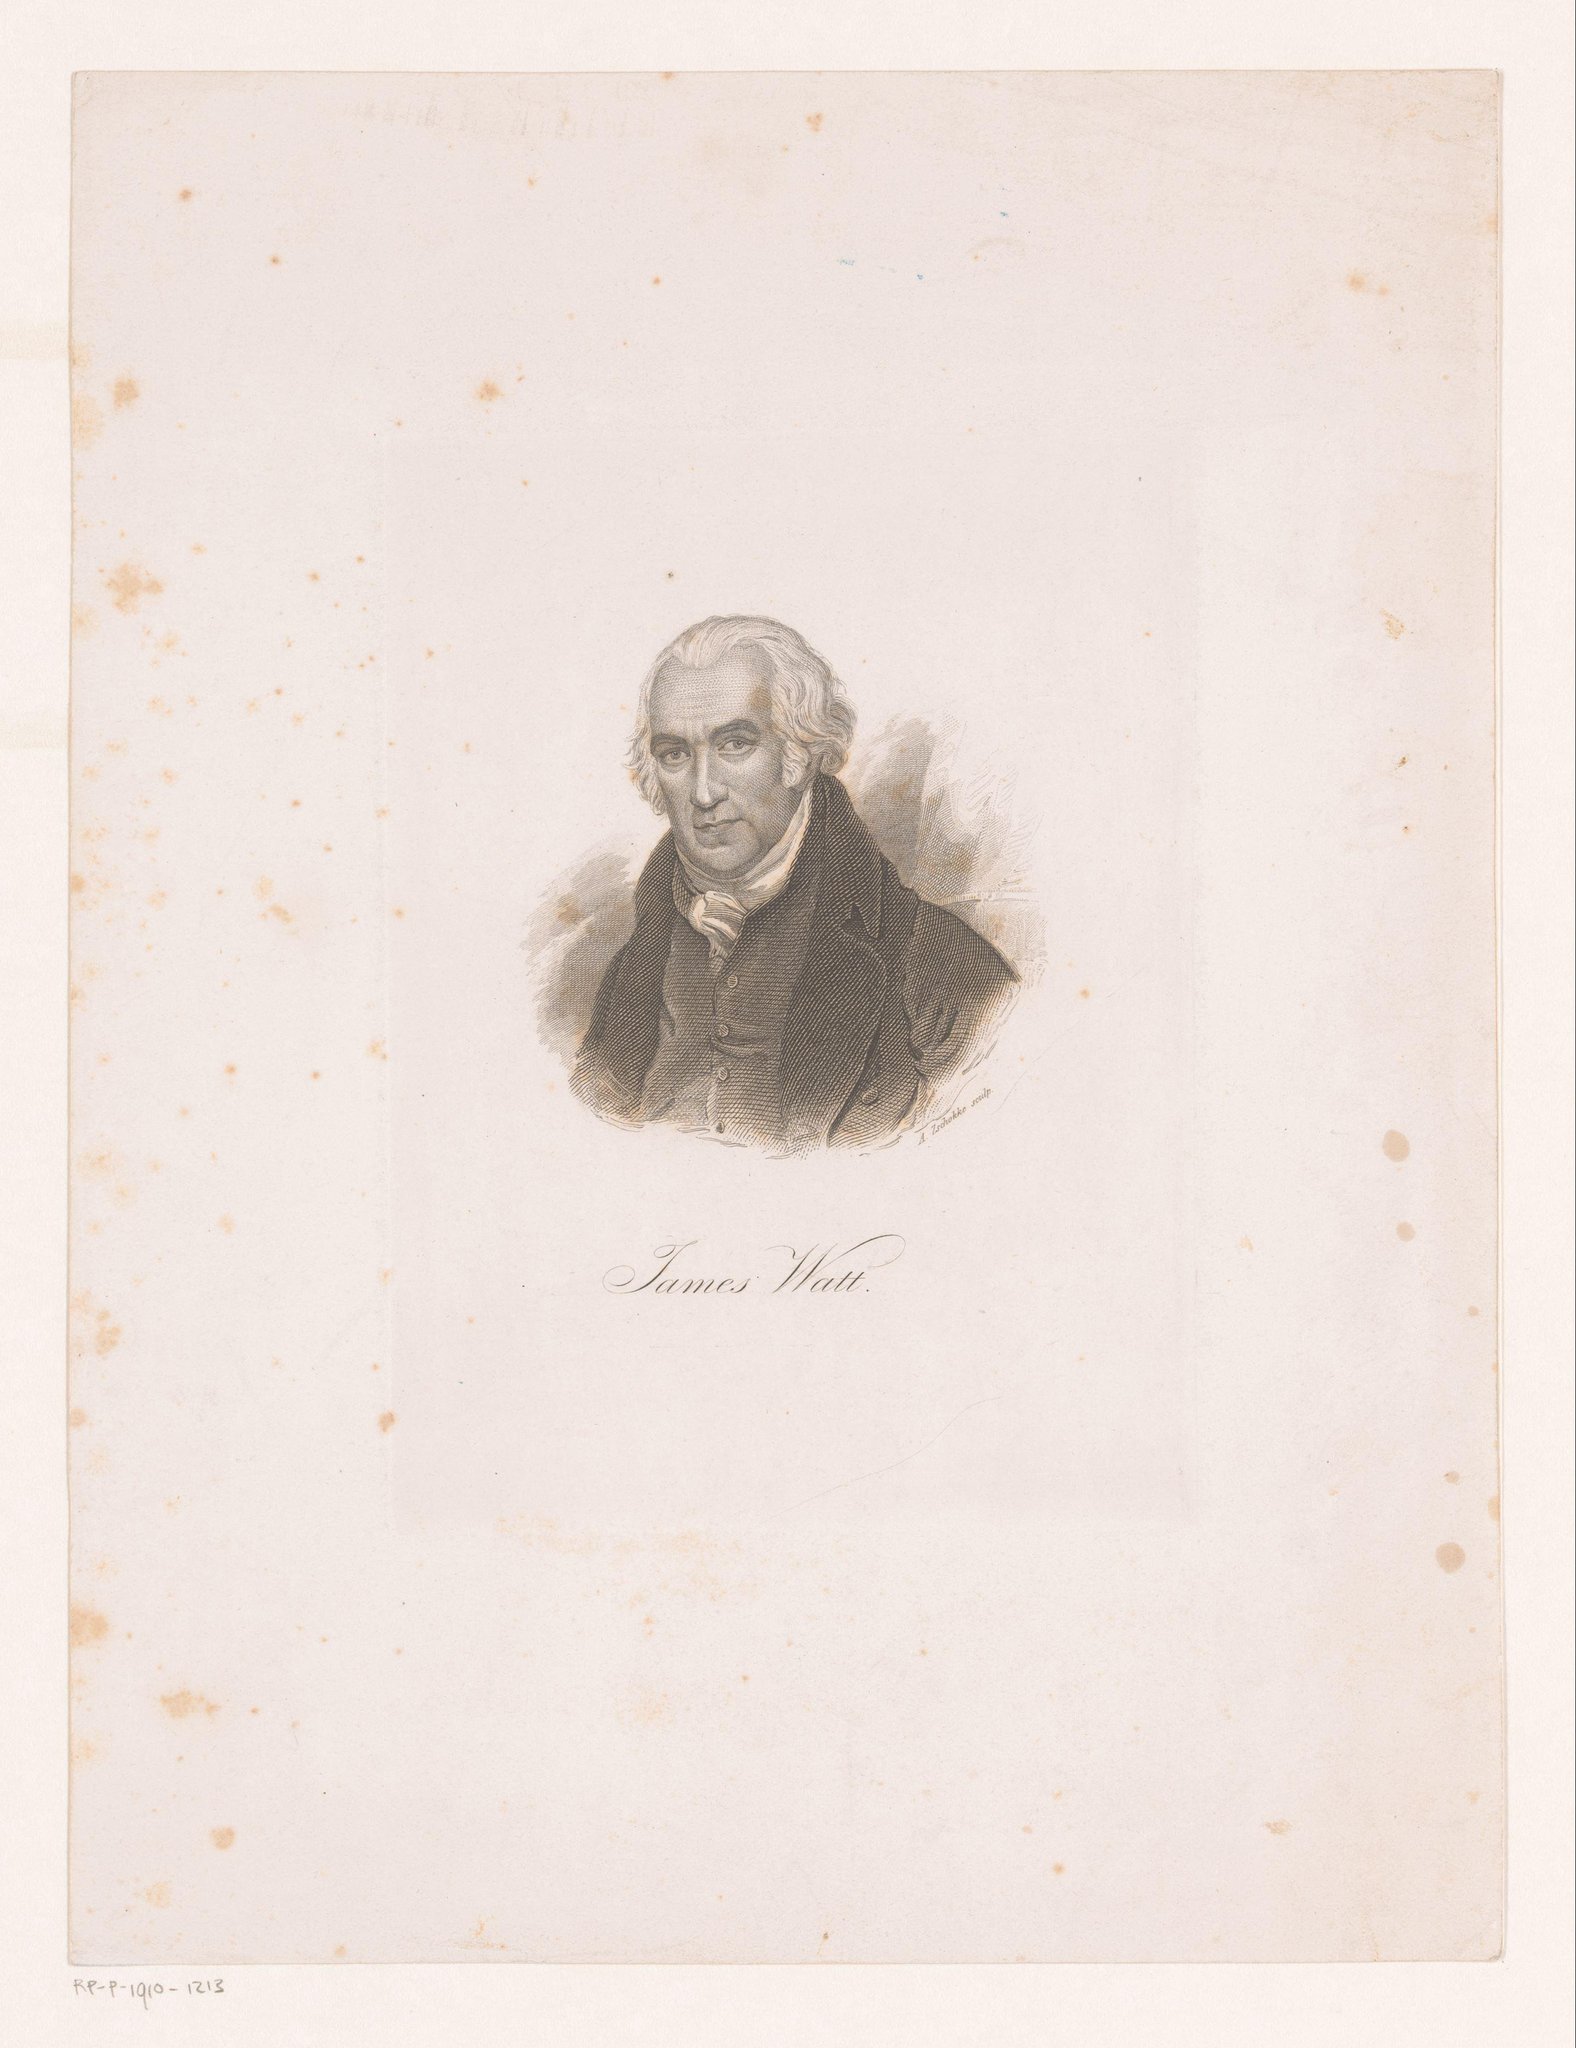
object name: print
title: Portret van James Watt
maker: alexander gottfried zschokke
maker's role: print maker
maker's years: 1811-1859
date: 1821-1859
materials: paper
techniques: engraving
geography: germany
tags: historical persons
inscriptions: collector's mark: Lugt 2228